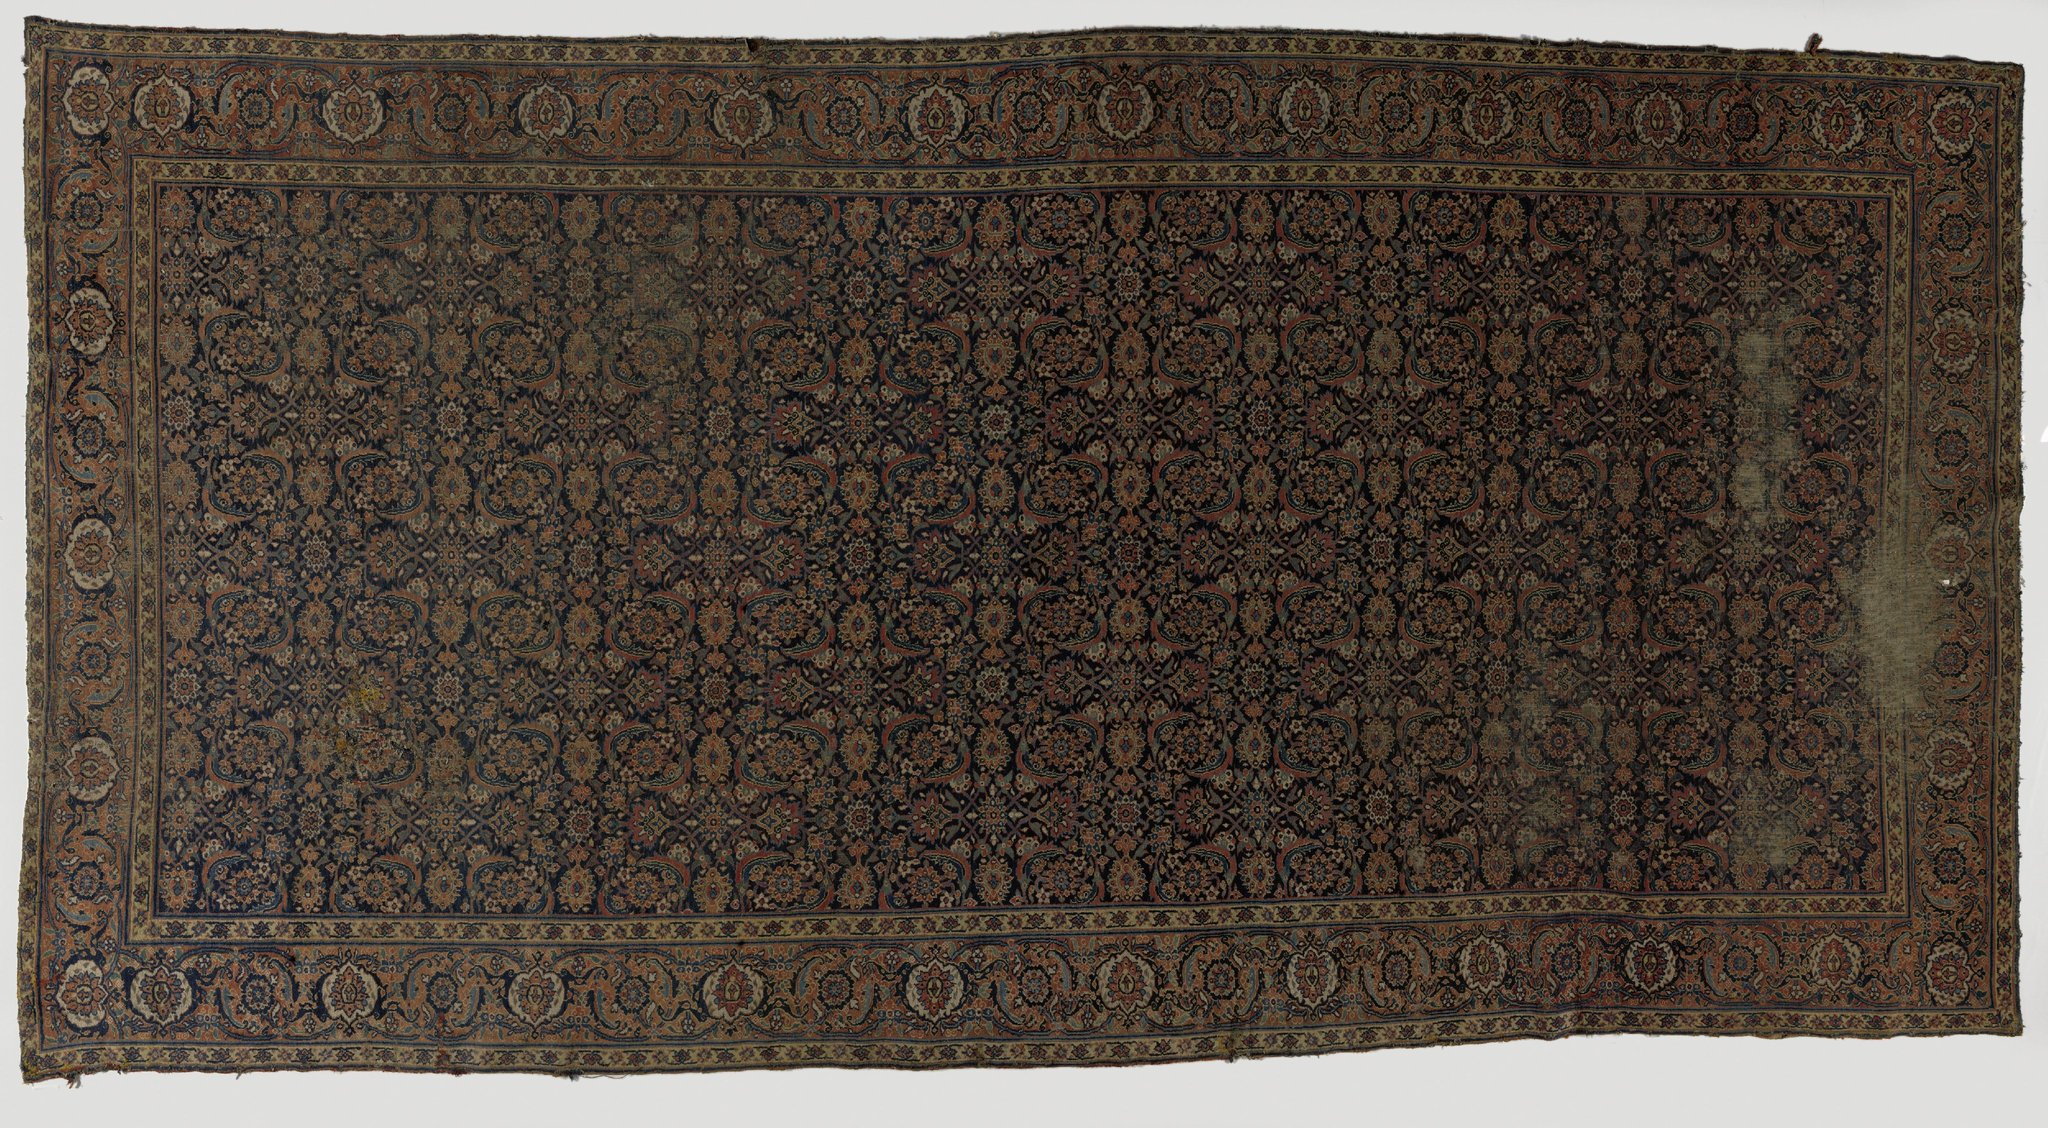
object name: oriental rug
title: Oosters tapijt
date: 1885-1900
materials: wool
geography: central persia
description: Oosters tapijt van geknoopte wol met Herati-patroon en drie randen, waarvan de middelste versierd is met ranken, arabesken en palmetten en rozetten.